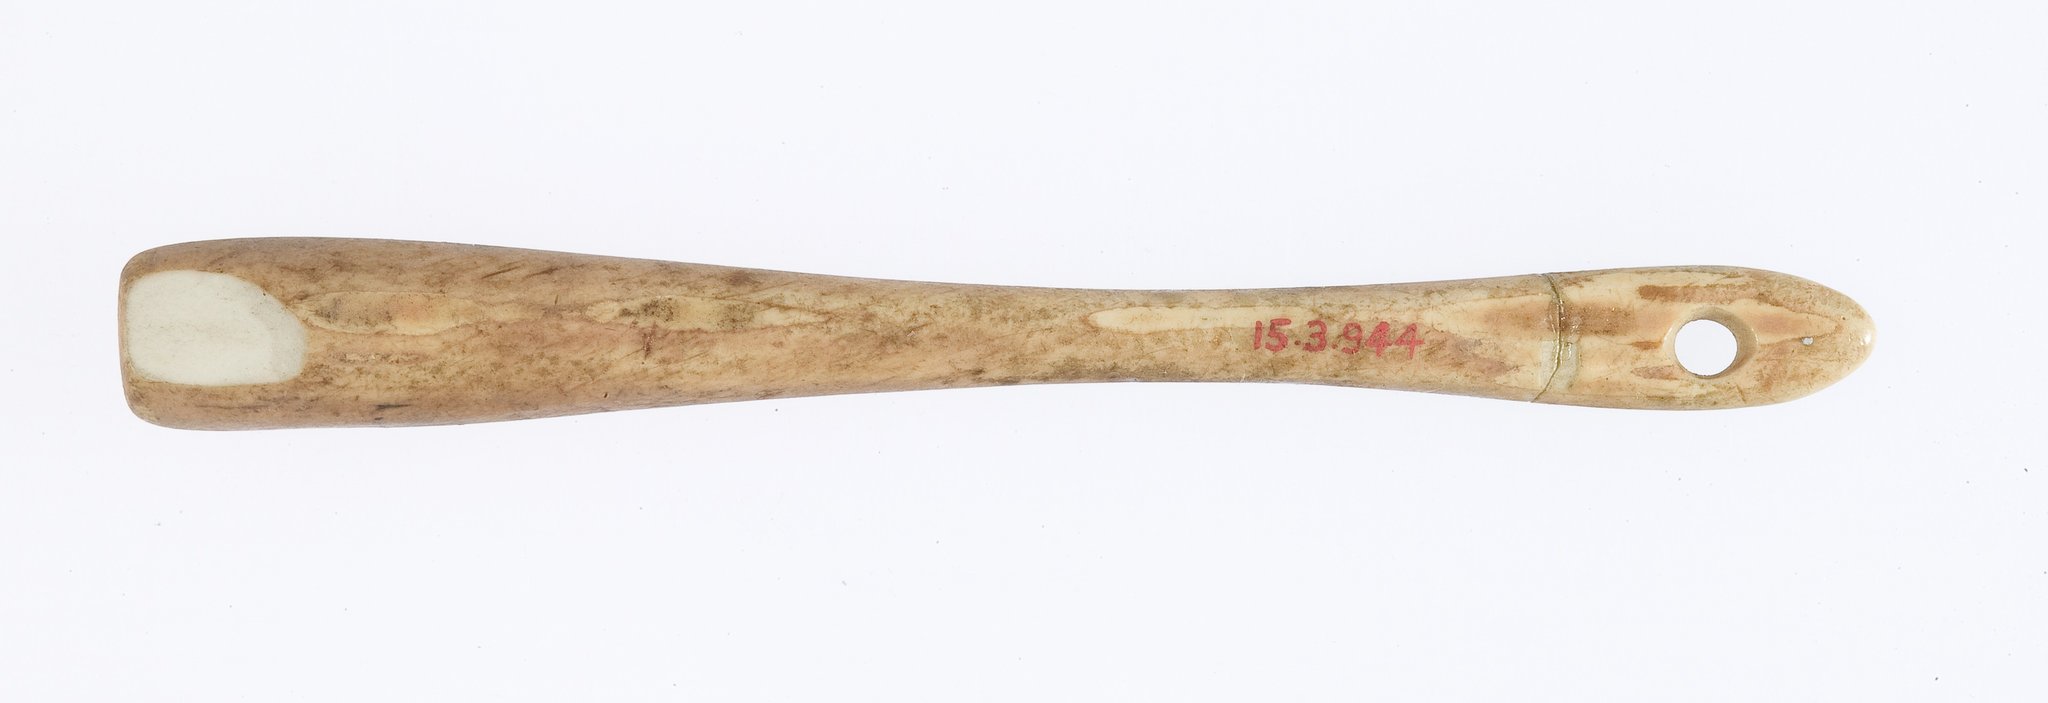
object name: fish net needle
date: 1295-1070 BCE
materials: ivory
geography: egypt